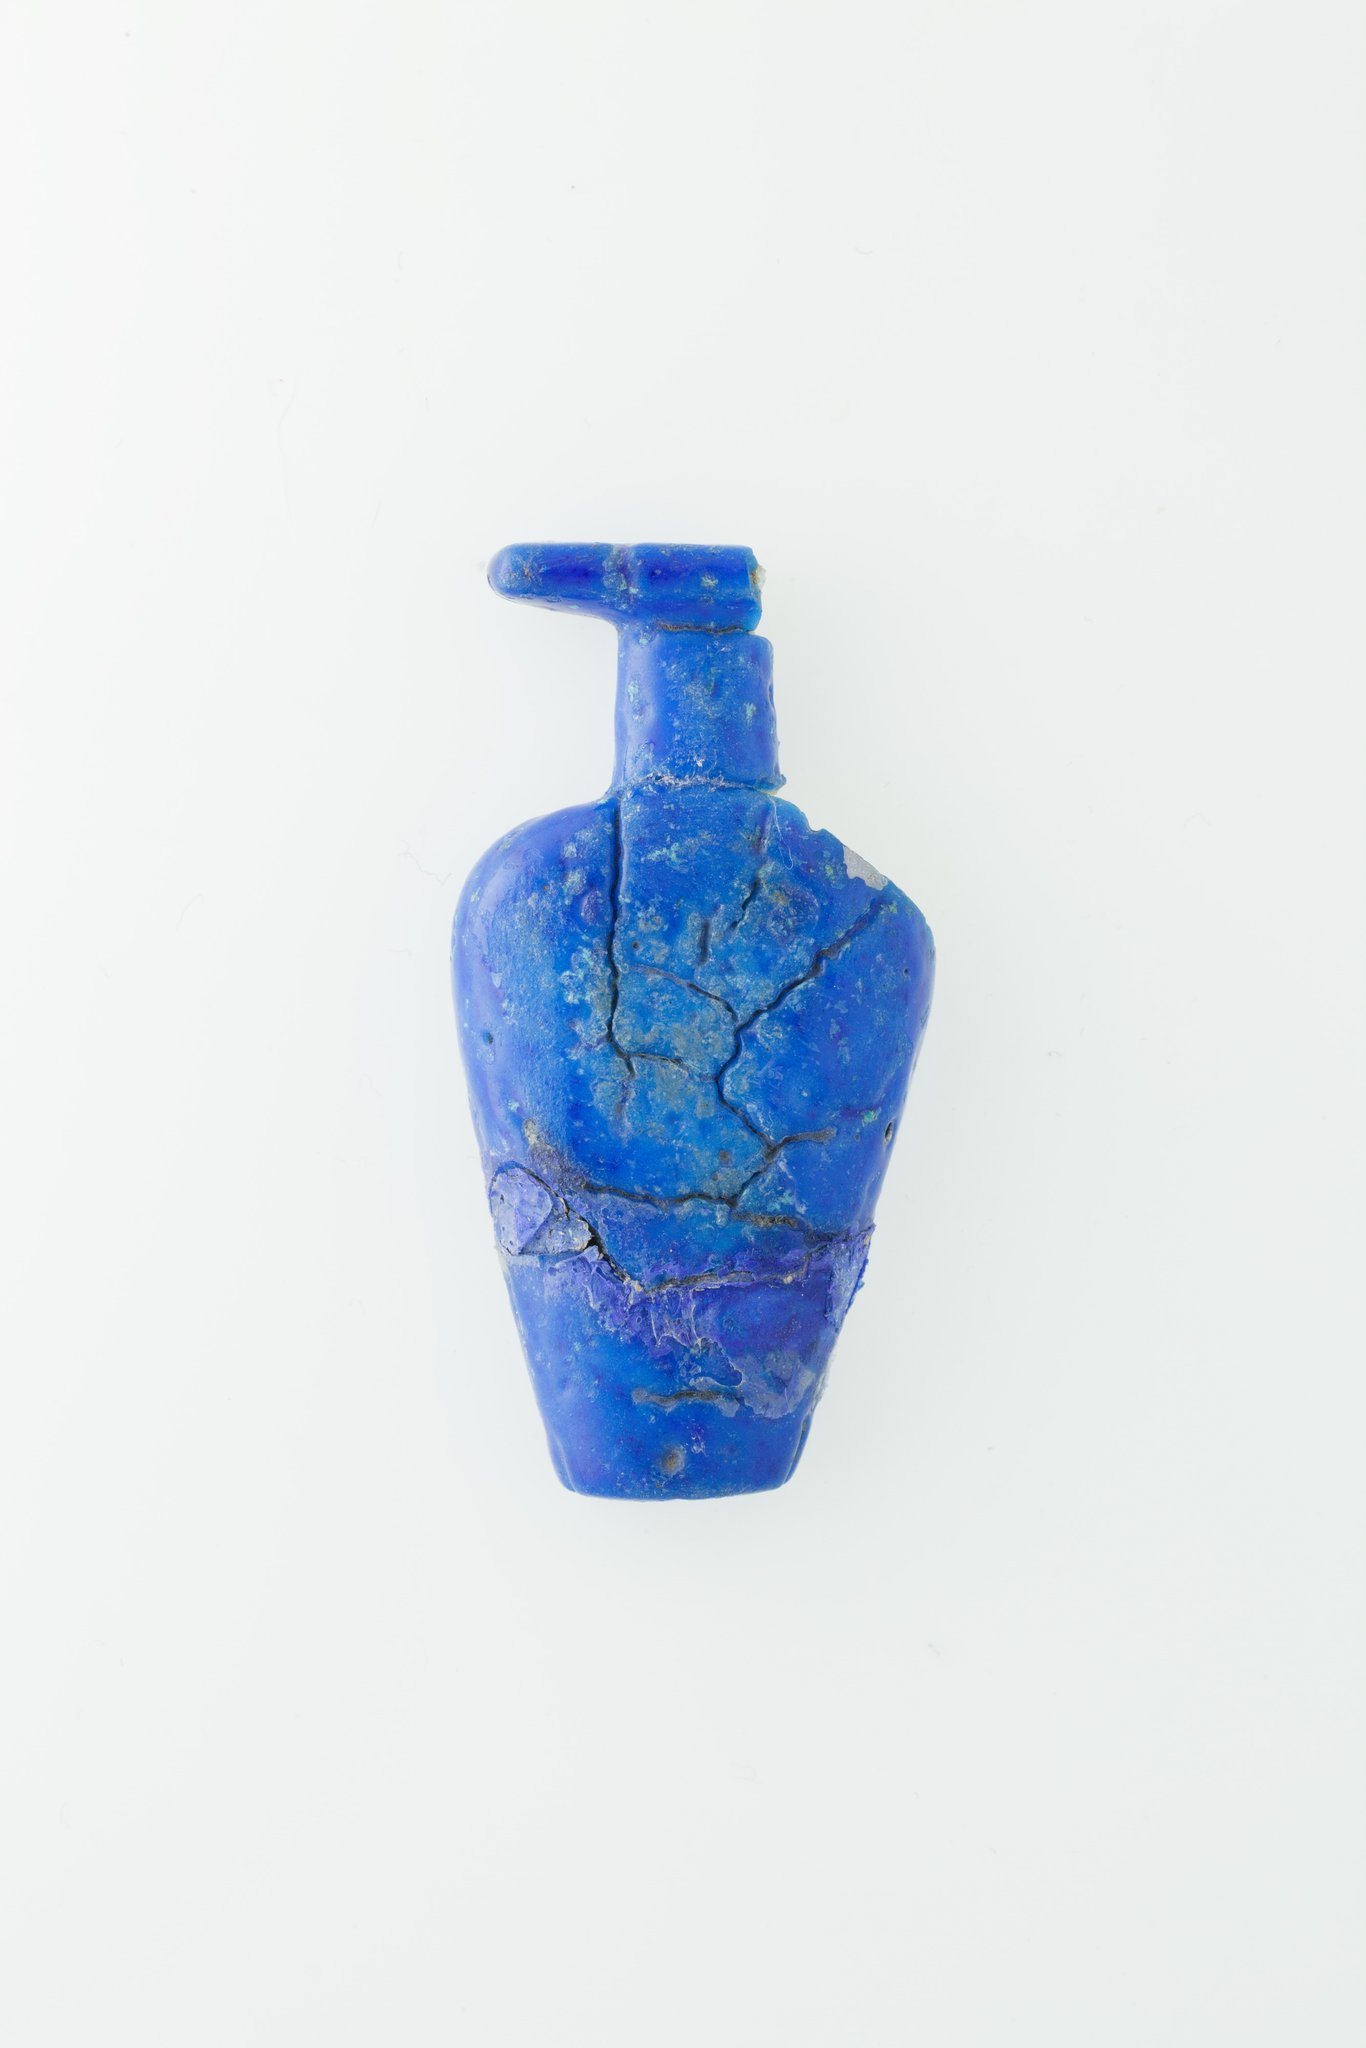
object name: inlay, hieroglyph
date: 664-610 BCE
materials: faience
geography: egypt